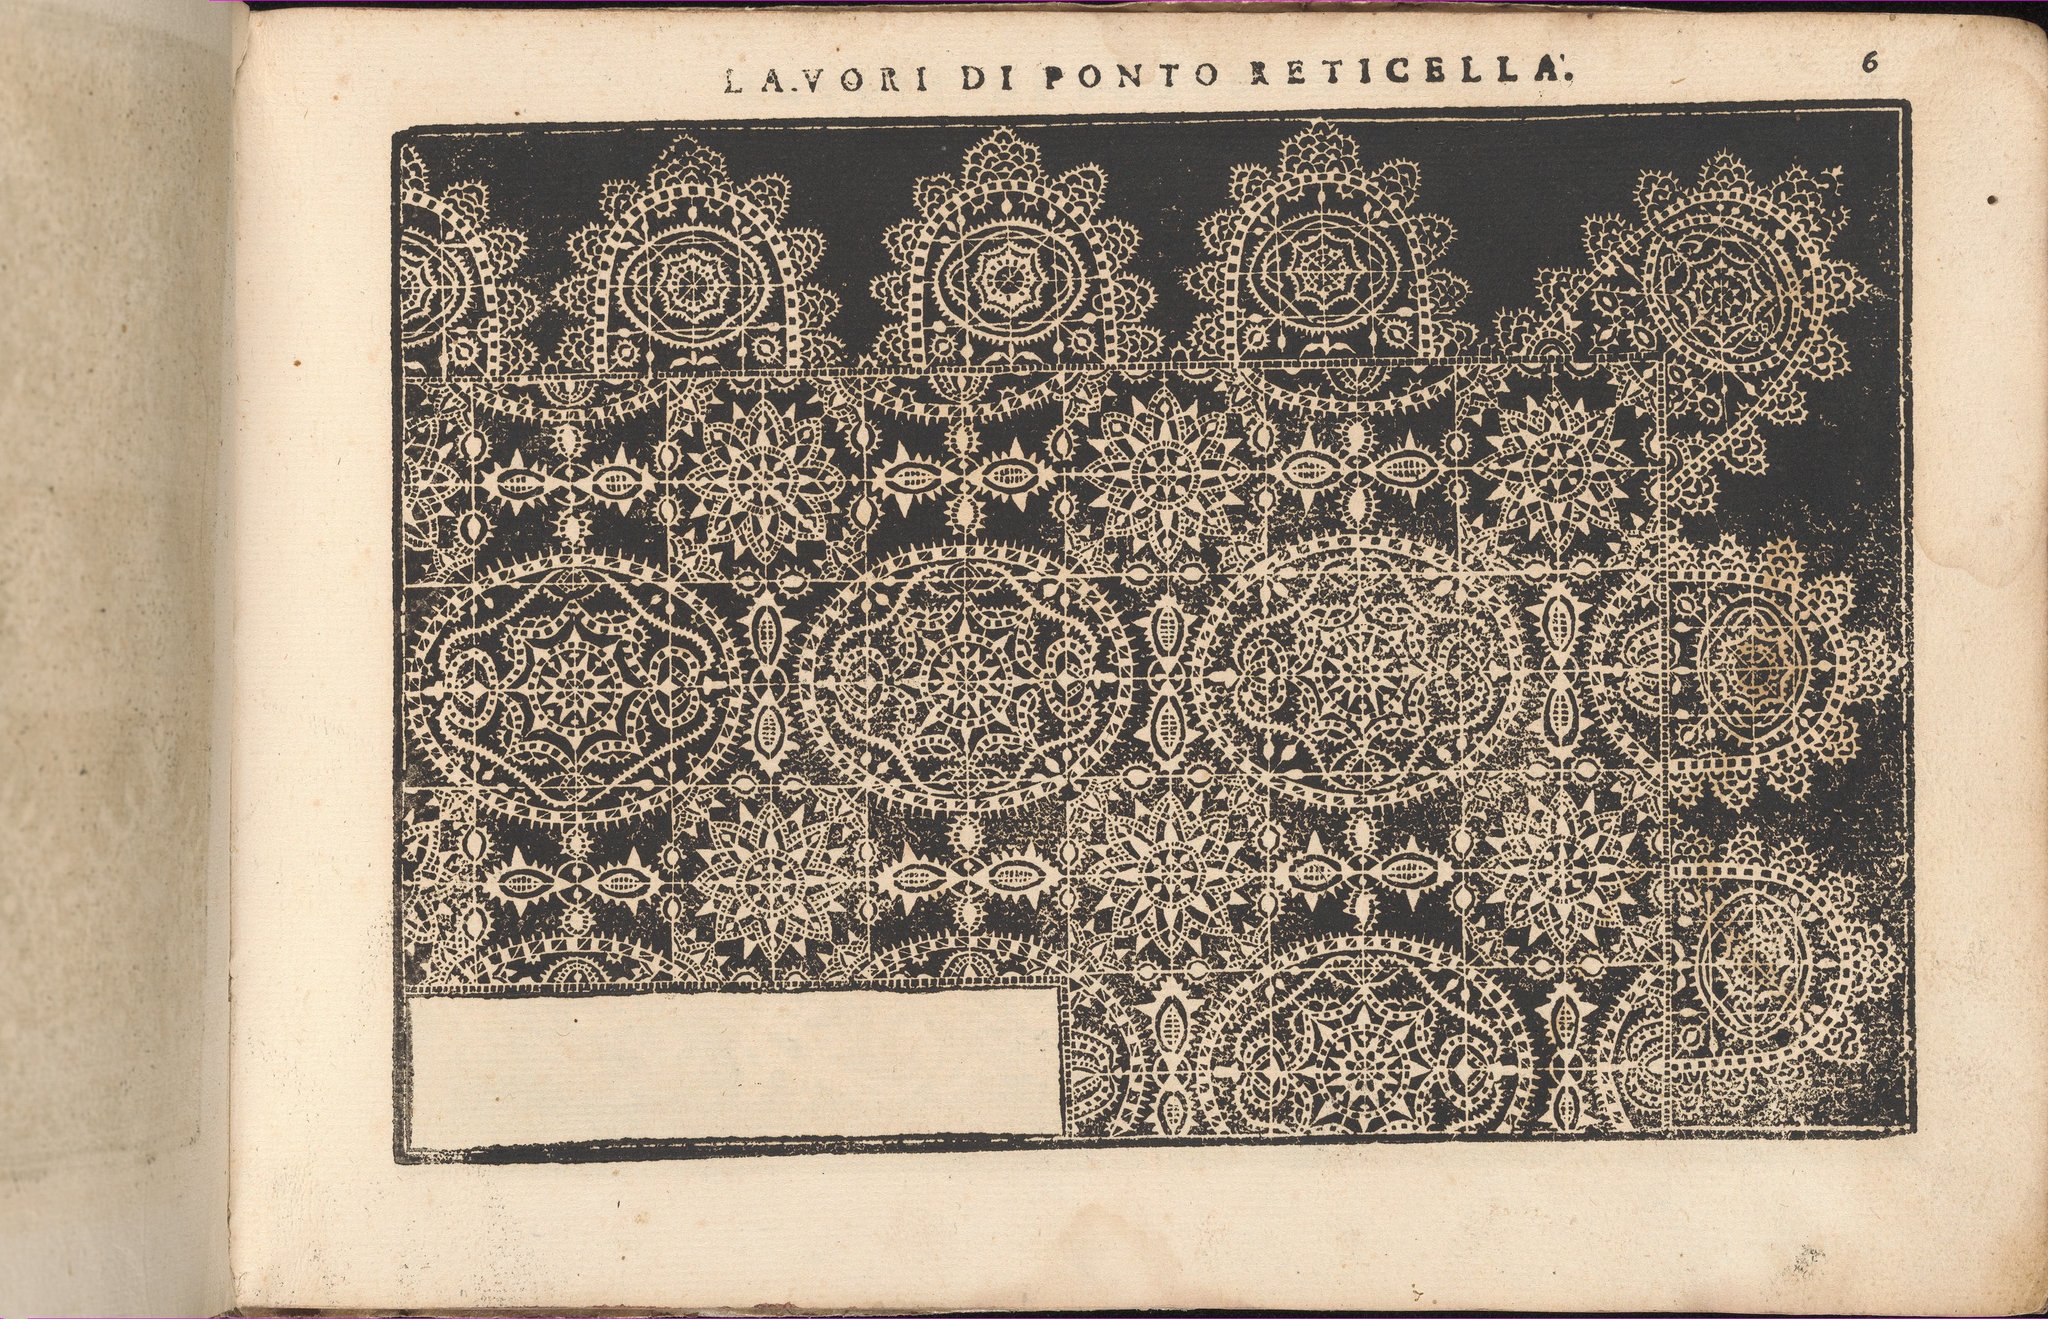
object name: book print ornament architecture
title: Teatro delle Nobili et Virtuose Donne..., page 4 (recto)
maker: isabella catanea parasole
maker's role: author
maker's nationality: italian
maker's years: 1565-1625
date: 1616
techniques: engraving, woodcut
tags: ornament